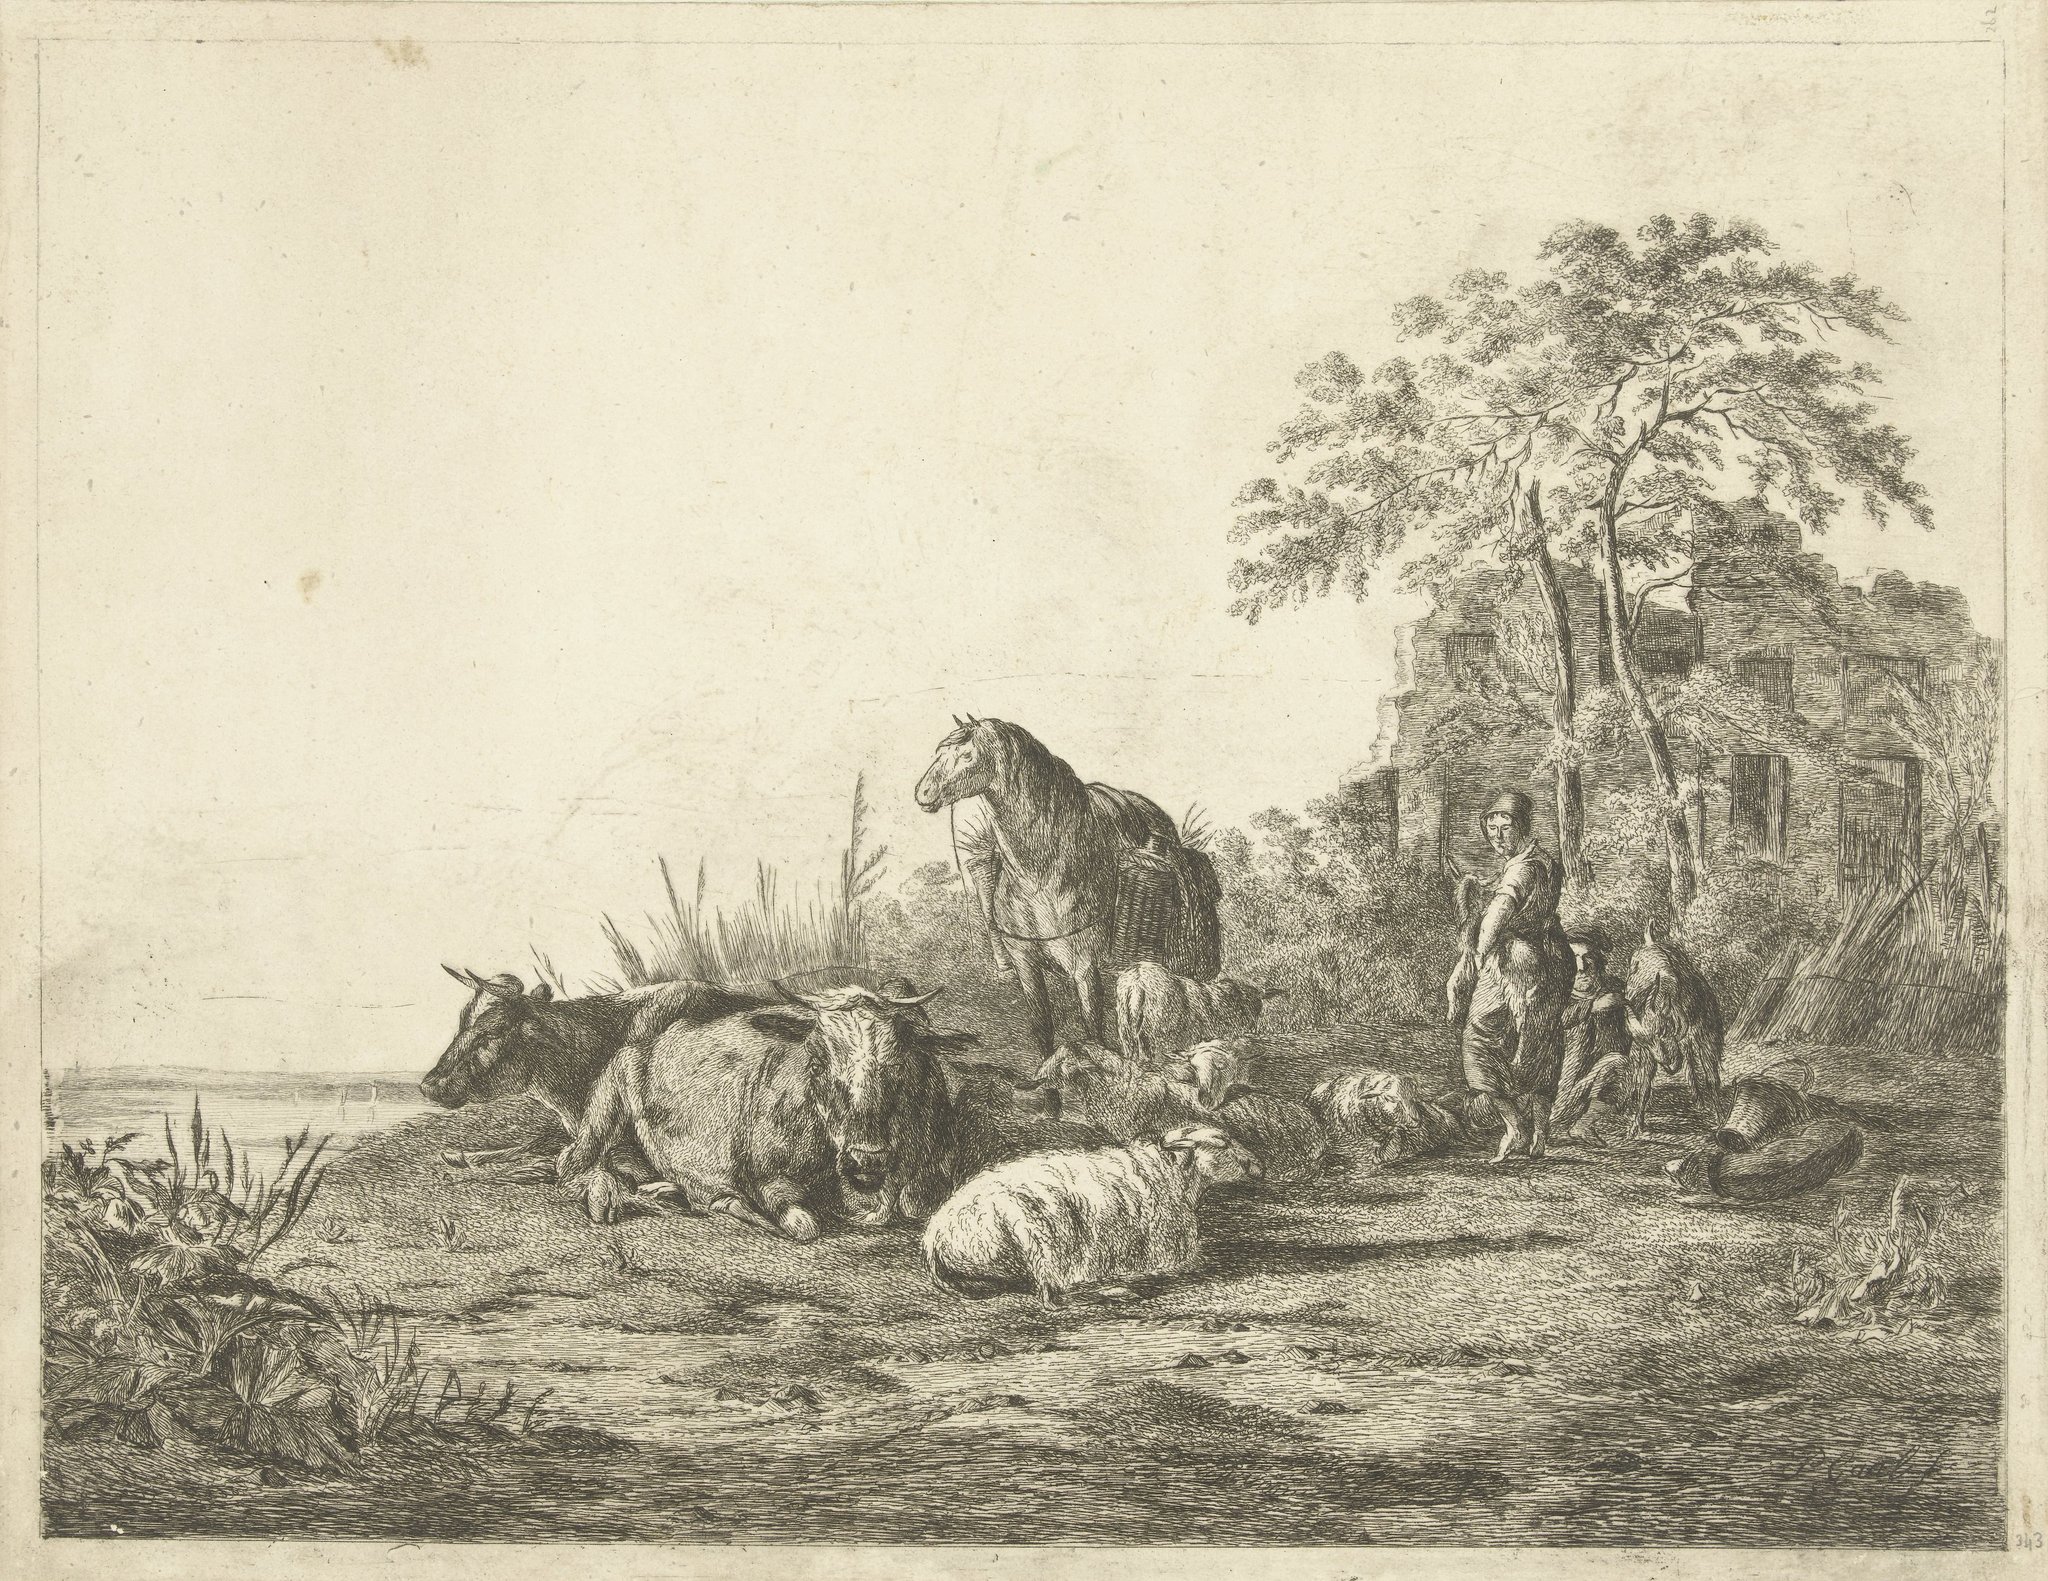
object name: print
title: Herder en herderin met kudde vee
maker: pieter gaal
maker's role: draughtsman, print maker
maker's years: 1769-1819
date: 1779-1819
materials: paper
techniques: etching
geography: netherlands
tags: herding, herdsman, herdswoman, shepherd, shepherdess, cowherd, etc., cattle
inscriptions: collector's mark: Lugt 2228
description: Bij een ruïne aan een plas staan een herderin en een herder met een kudde vee bestaande uit twee koeien, zes schapen en twee geiten. Een paard beladen met manden met stro staat tussen de dieren in.